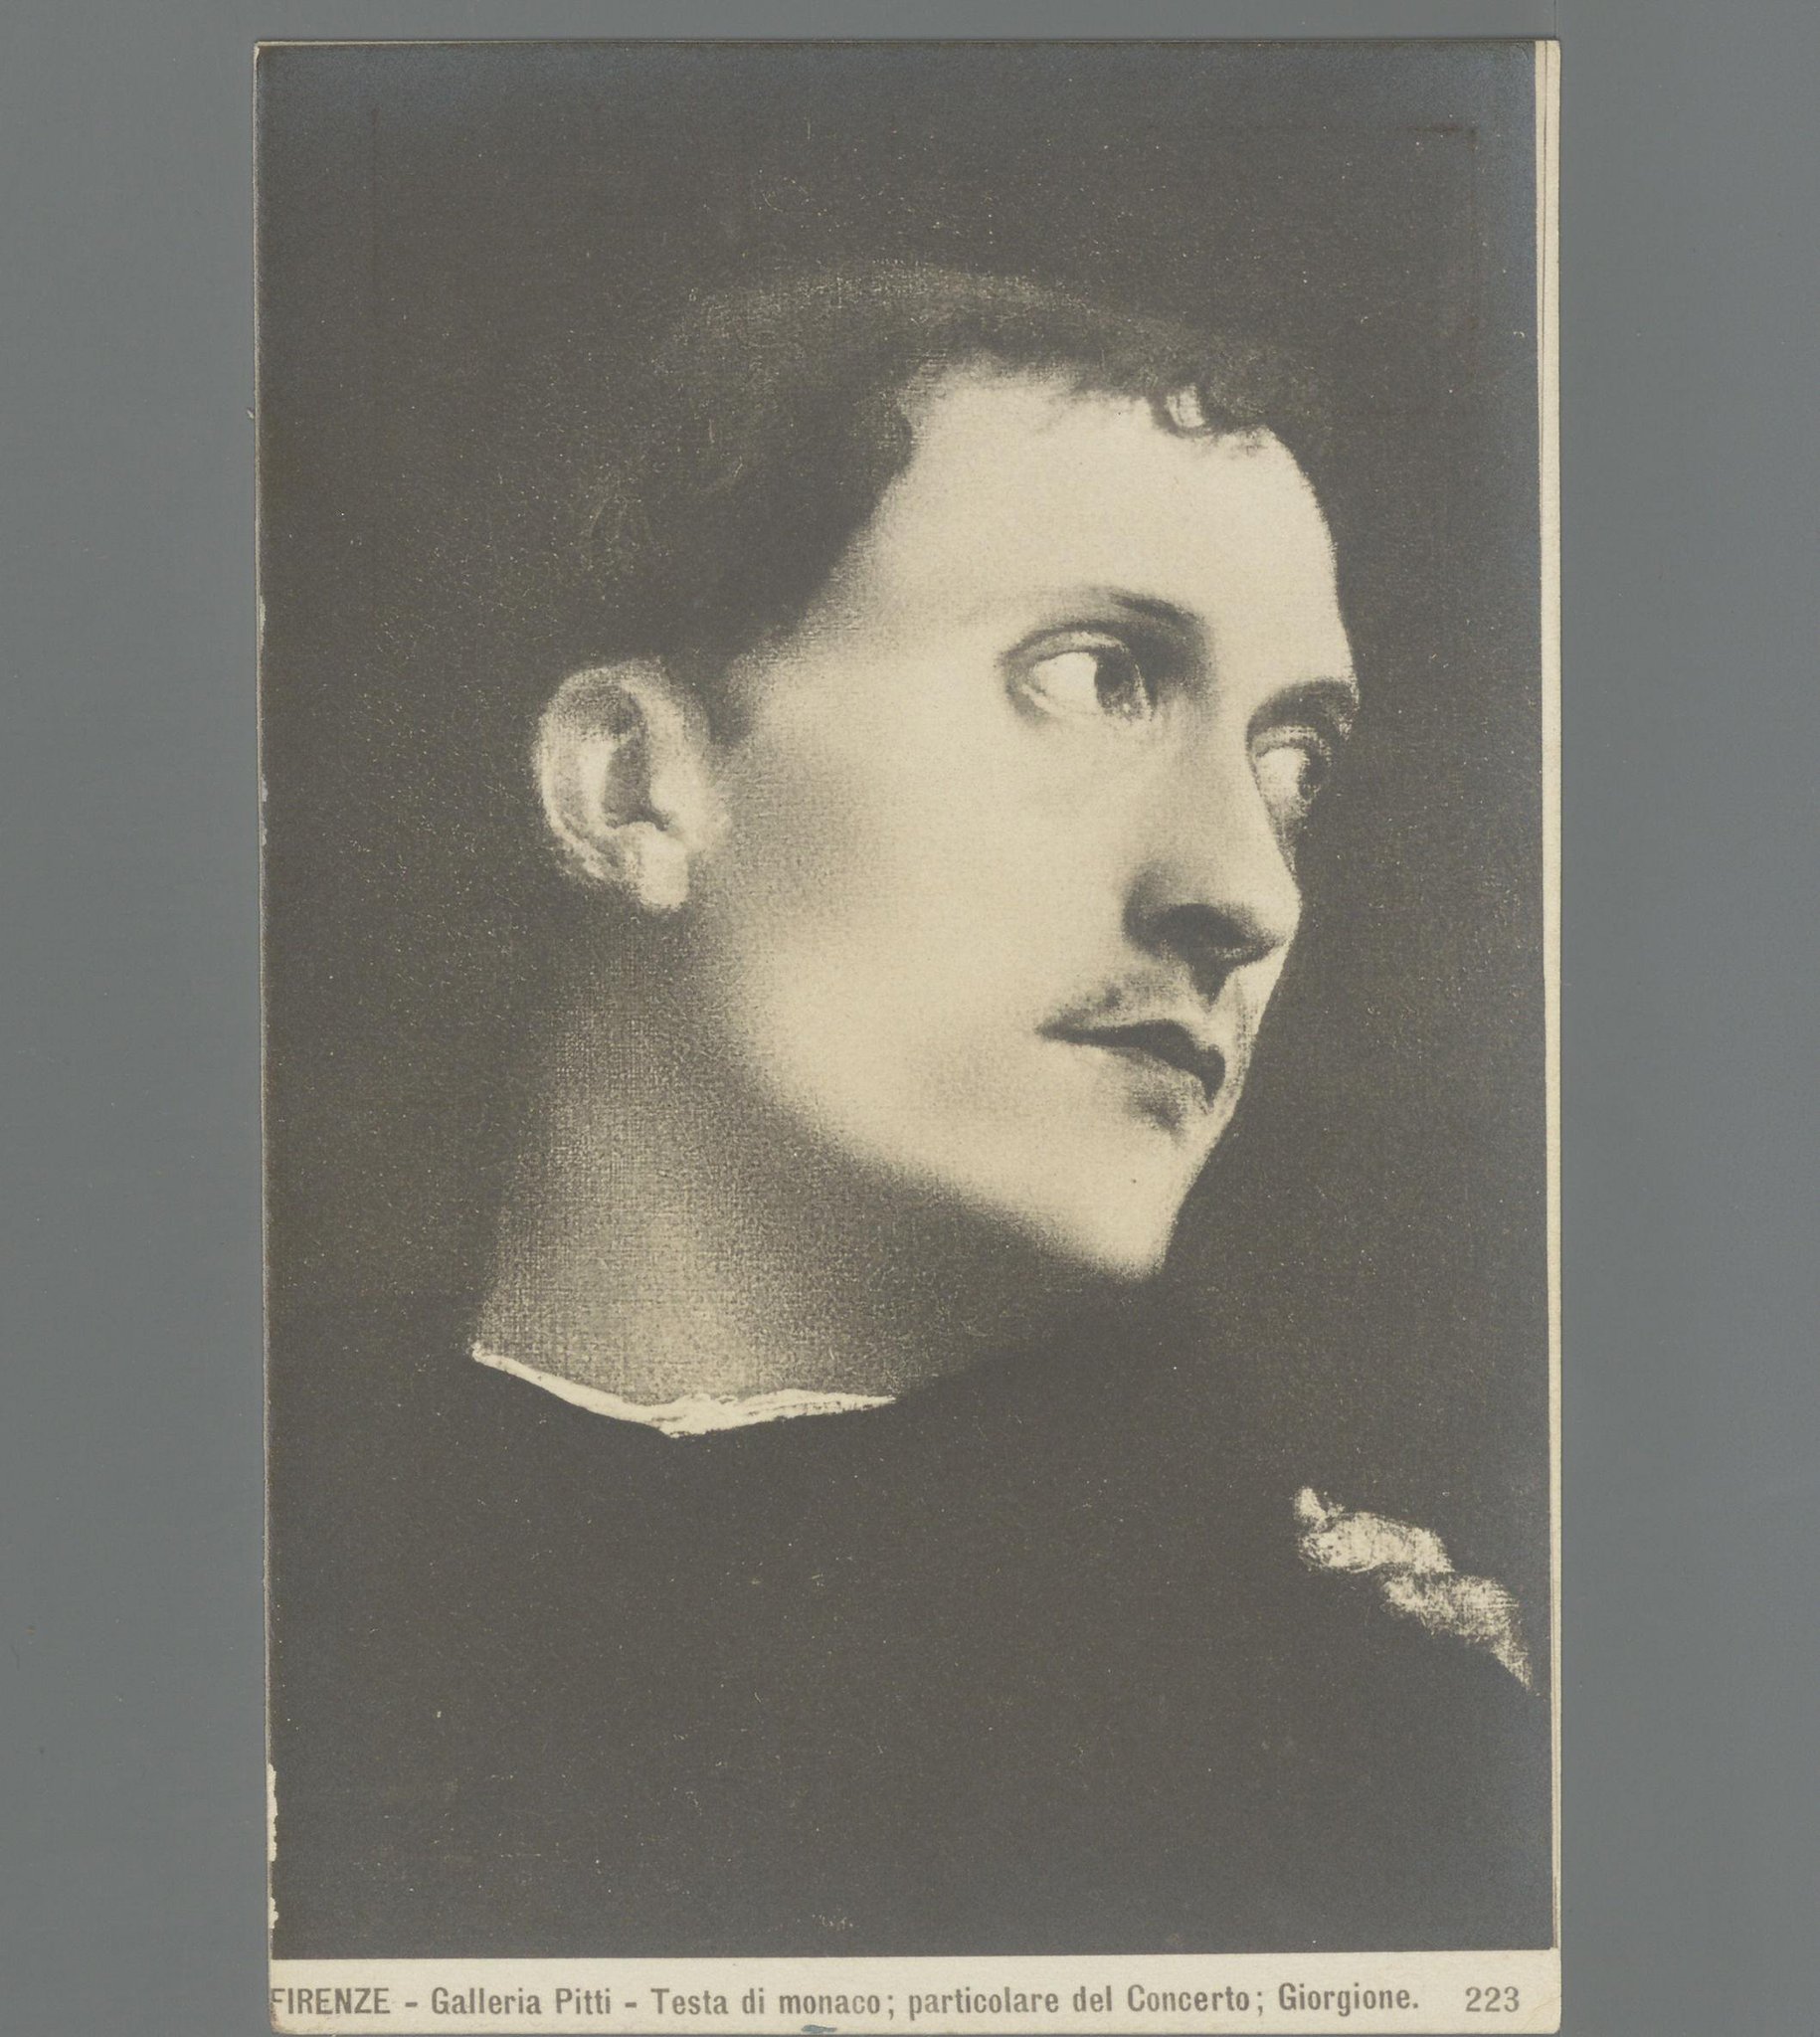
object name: ansichtkaart, prentbriefkaart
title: Firenze. Galleria Pitti. Testa di monaco; particolare del Concerto; Giorgione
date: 1906-1930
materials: photographic support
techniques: photography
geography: florence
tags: monk(s), friar(s)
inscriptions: collector's mark: ‘AFE v S’